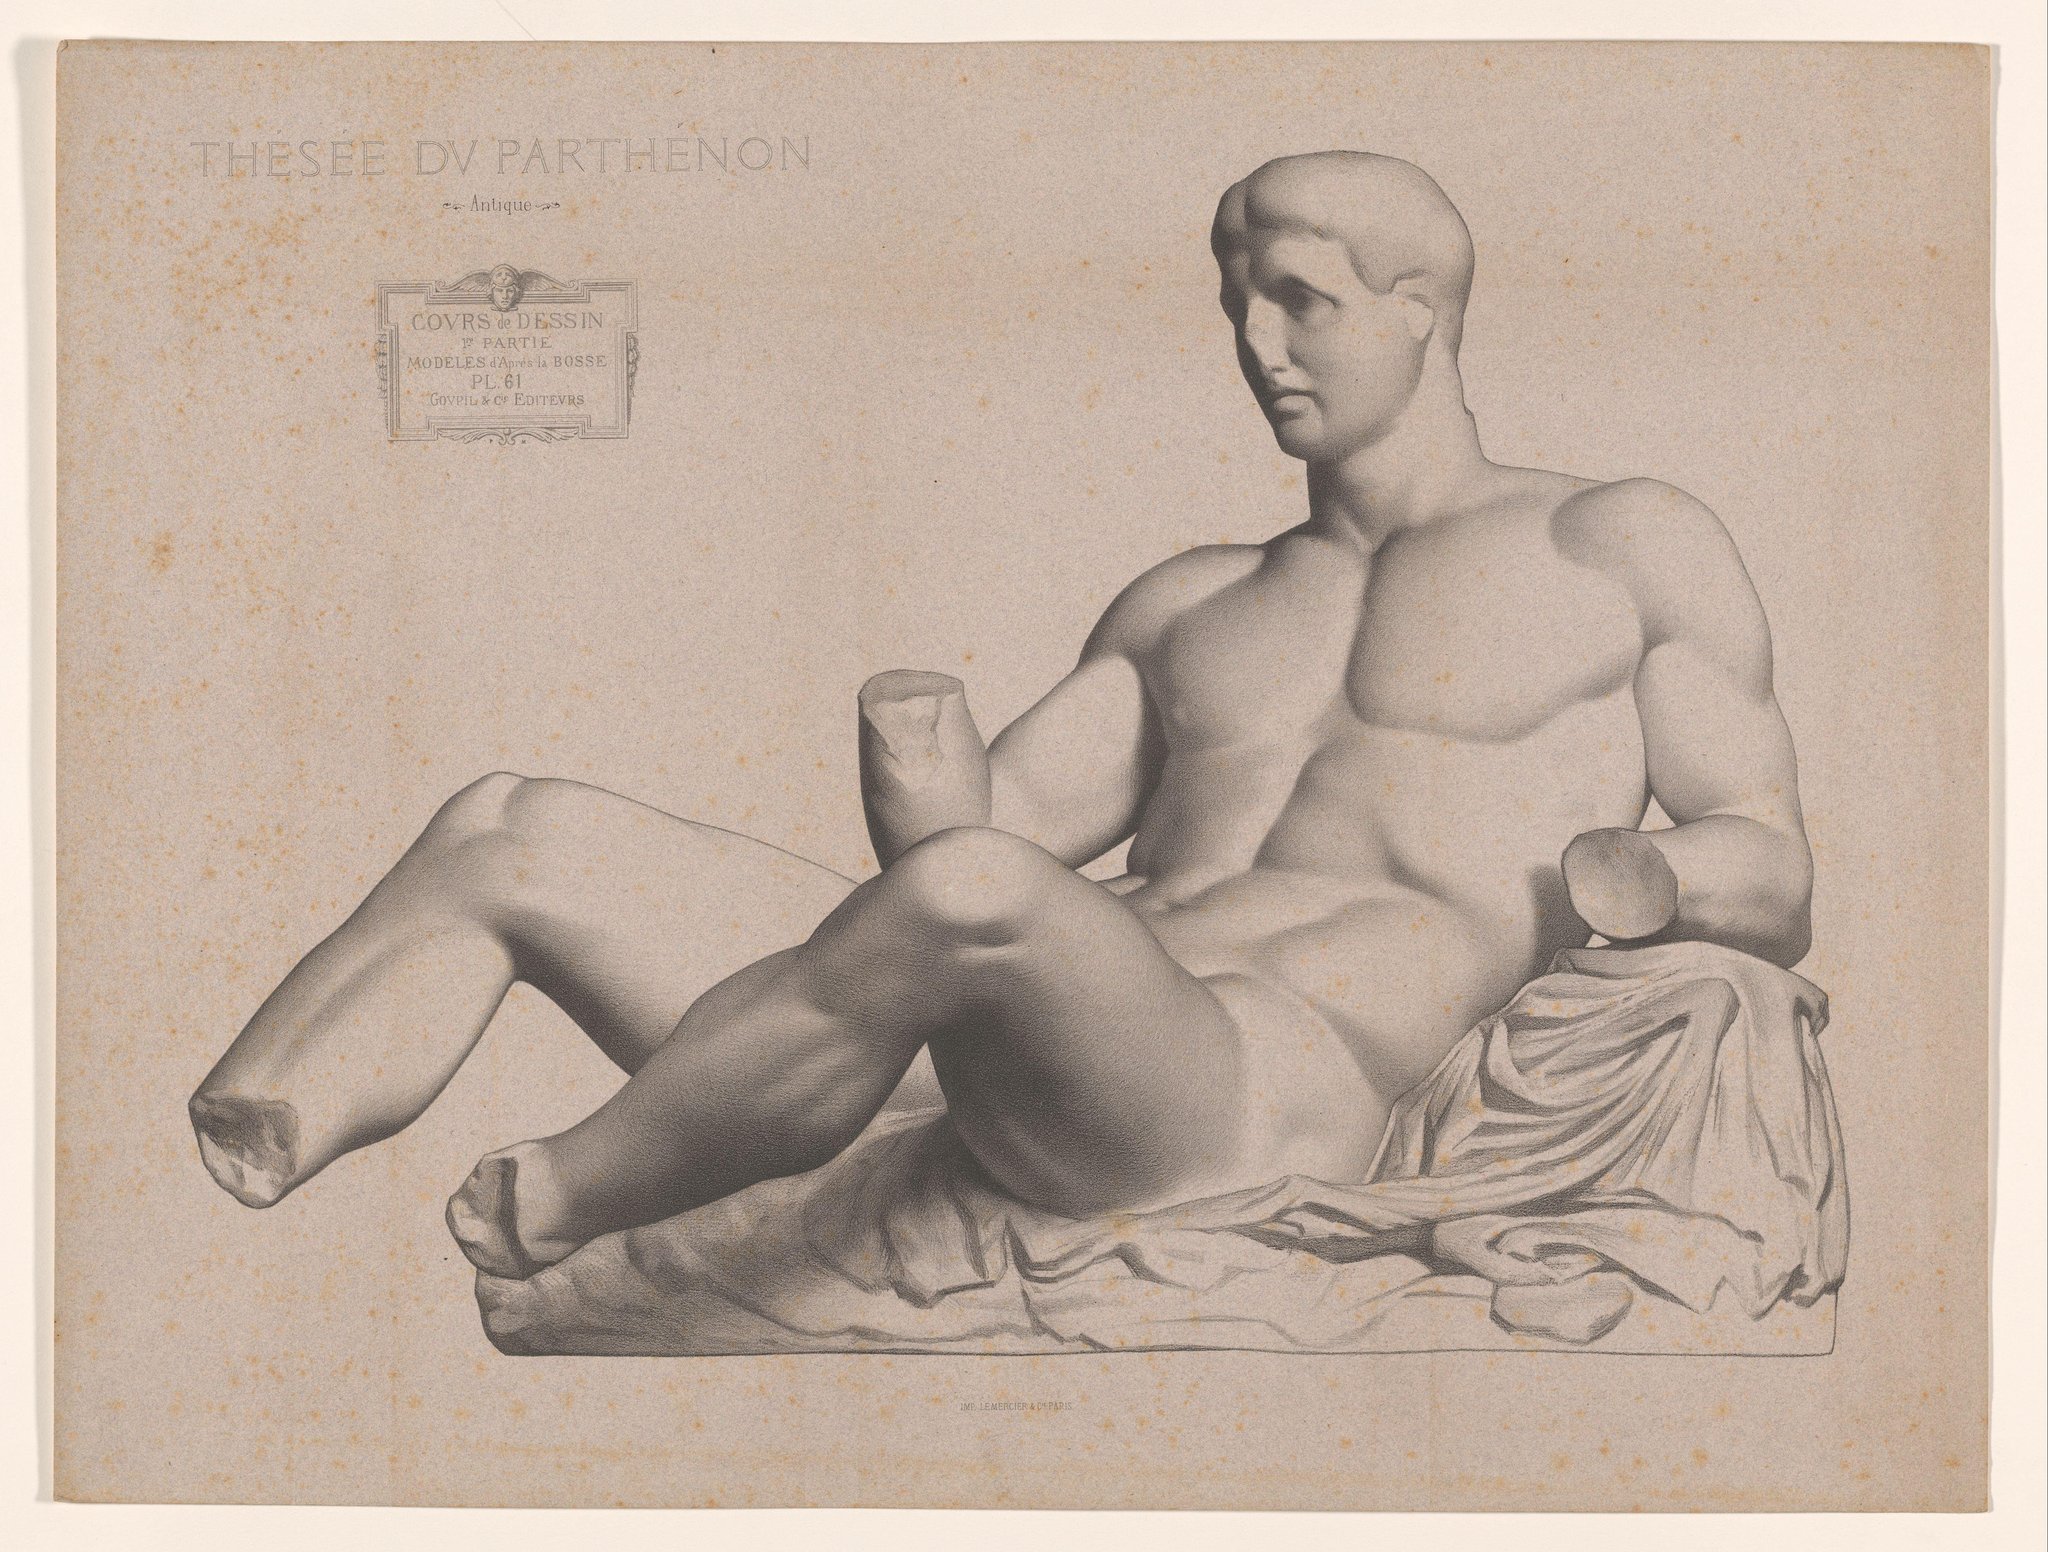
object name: print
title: Theseus, deel van het fronton van het Parthenon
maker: charles bargue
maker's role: print maker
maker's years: 1825-1883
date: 1866-1871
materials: paper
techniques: lithograph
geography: paris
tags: piece of sculpture, reproduction of a piece of sculpture, (story of) theseus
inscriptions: stamp: ‘VOSMAER’, check stamp: Lugt 1090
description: Onderdeel van het eerste deel van Charles Bargue's en Jean-Léon Gérôme's 'Cours de dessin' tekencursus, uitgegeven tussen 1866 en 1871.